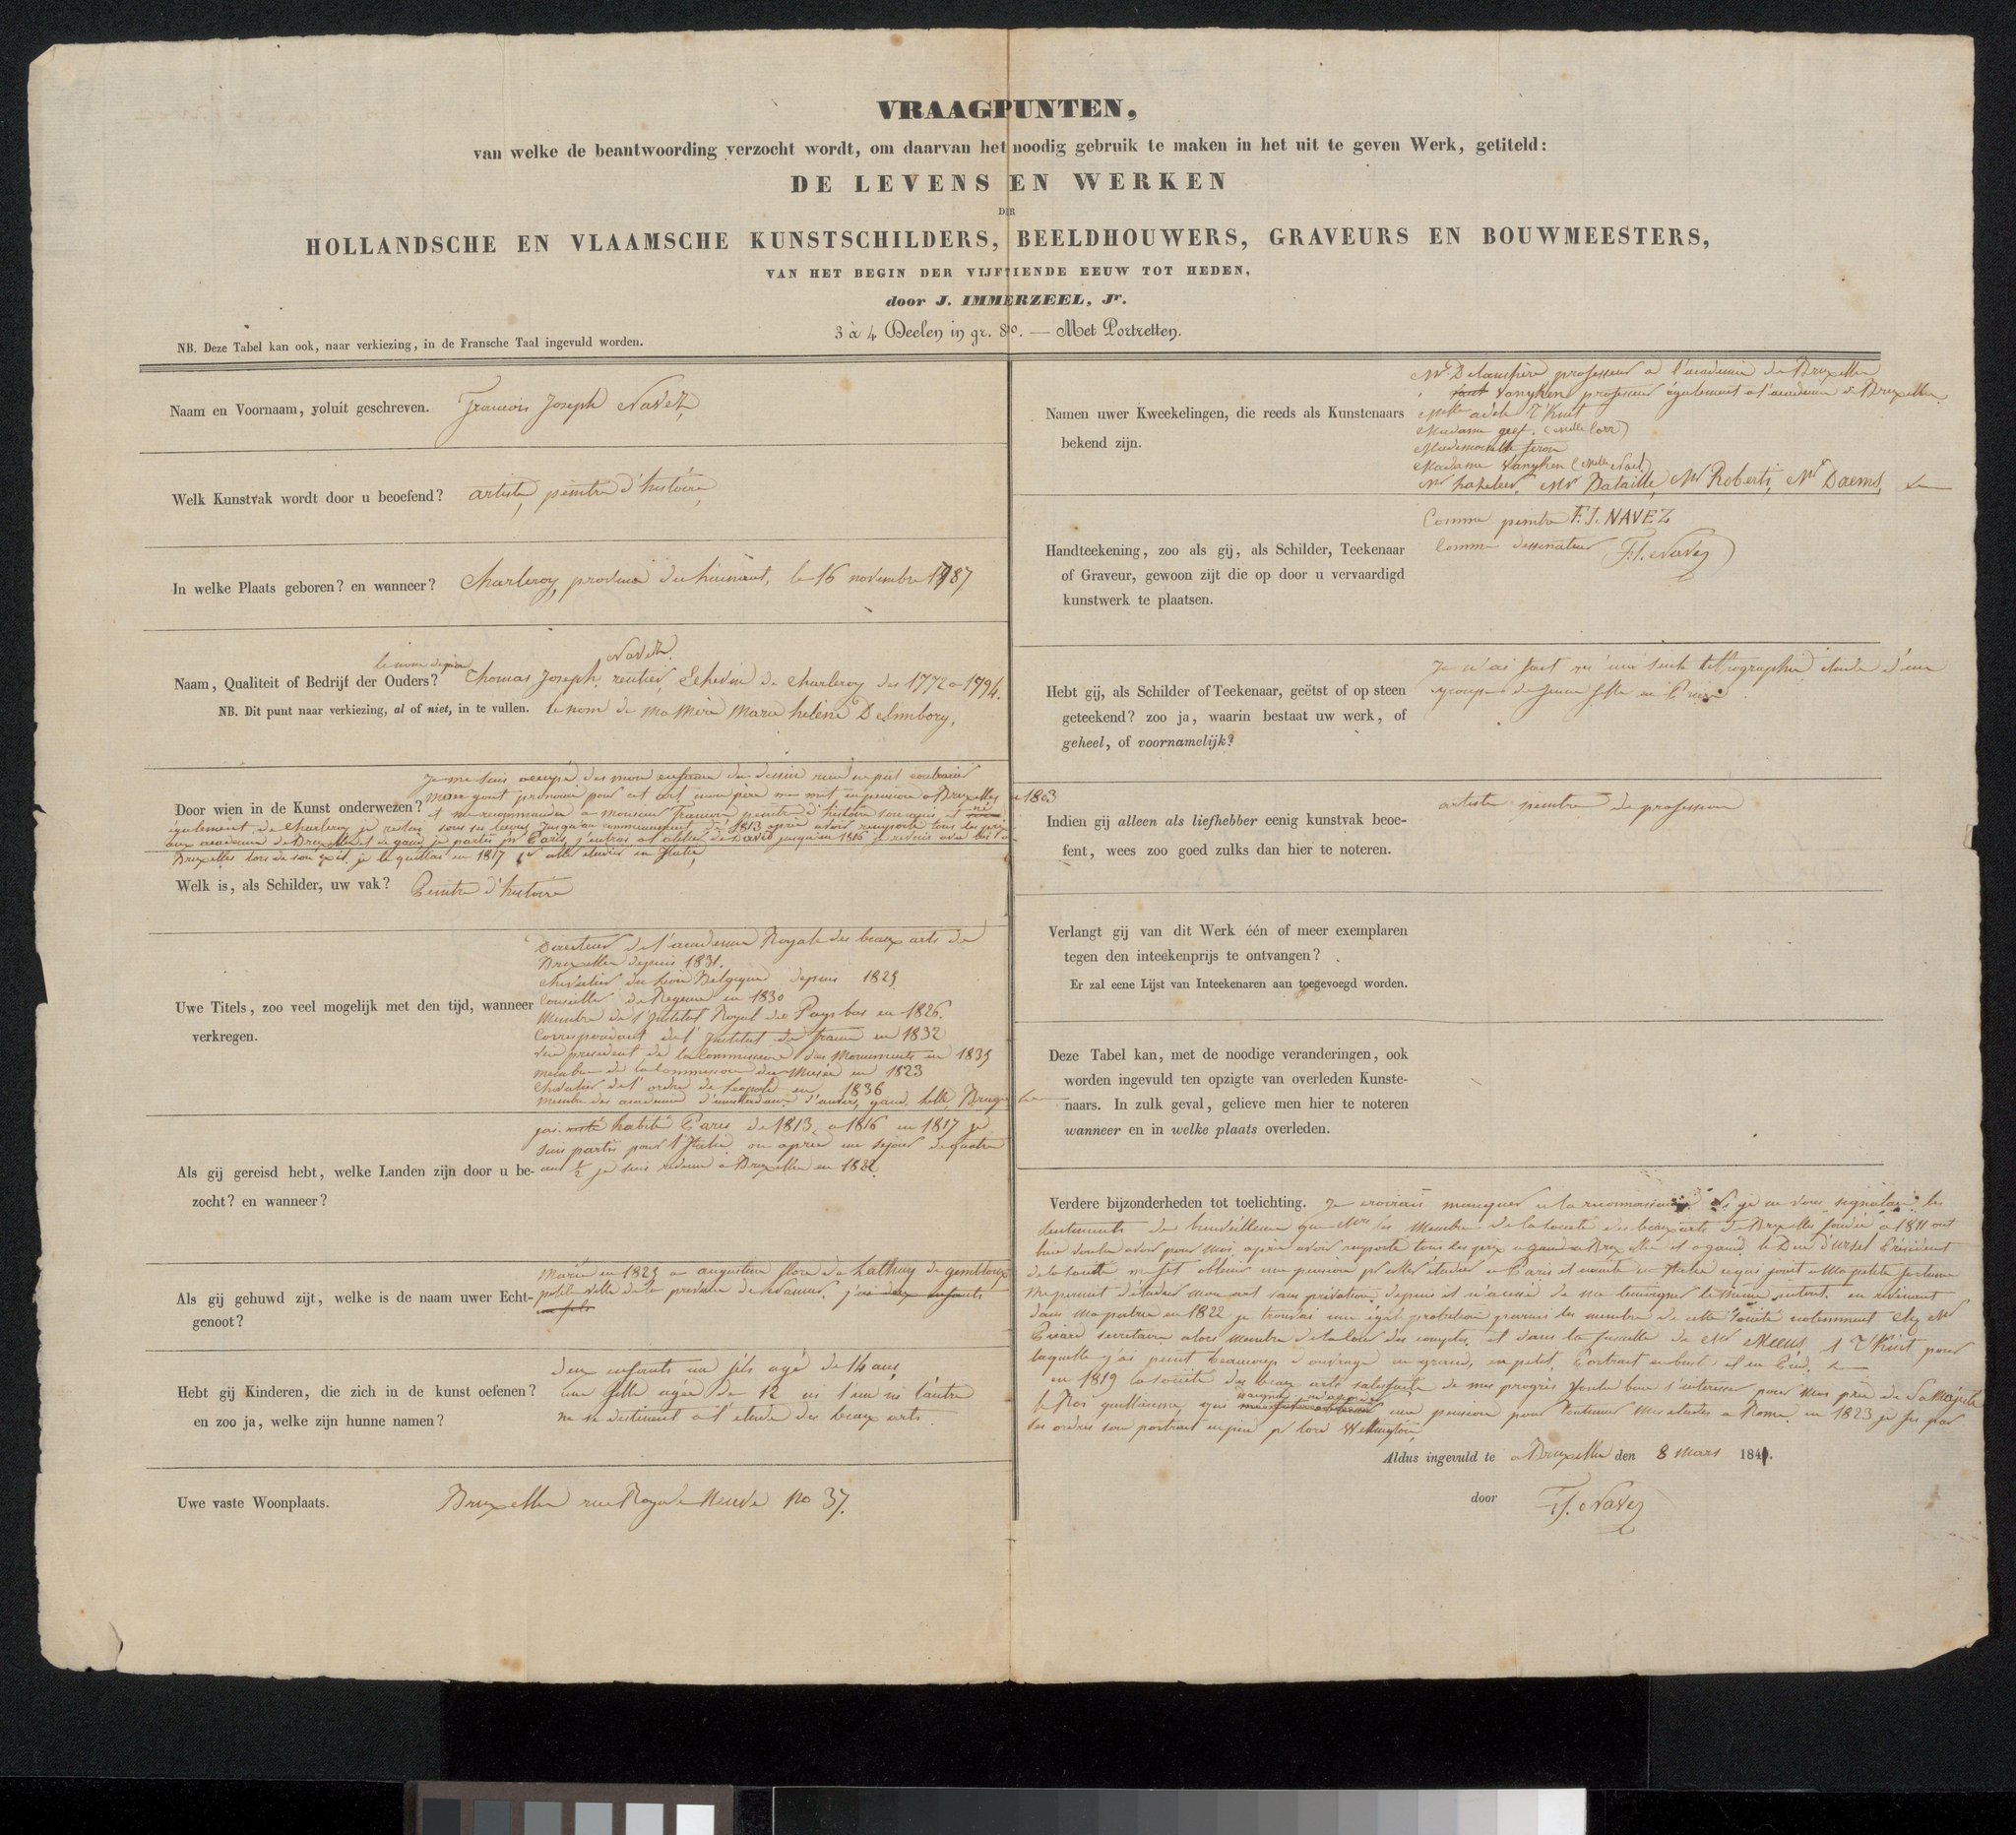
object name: questionnaire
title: Enquêteformulier ingevuld door François Joseph Navez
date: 1841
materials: ink, paper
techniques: pen, printing, writing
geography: brussels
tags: painter, draughtsman, françois joseph navez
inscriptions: inscription: ‘Vraagpunten,/ van welke de beantwoording verzocht wordt, om daarvan het noodig gebruik te maken in het uit te geven Werk, getiteld: De levens en werken/ der Hollandsche en Vlaamsche kunstschilders, beeldhouwers,/ graveurs en bouwmeesters, van het begin der vijftiende eeuw tot heden/ door J. Immerzeel, Jr.’, watermark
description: Opgenomen in: Immerzeel, J. Jr., De levens en werken der Hollandsche en Vlaamsche kunstschilders, beeldhouwers, graveurs en bouwmeesters, van het begin der vijftiende eeuw tot heden, Amsterdam: J.C. van Kesteren, 1842-1843.